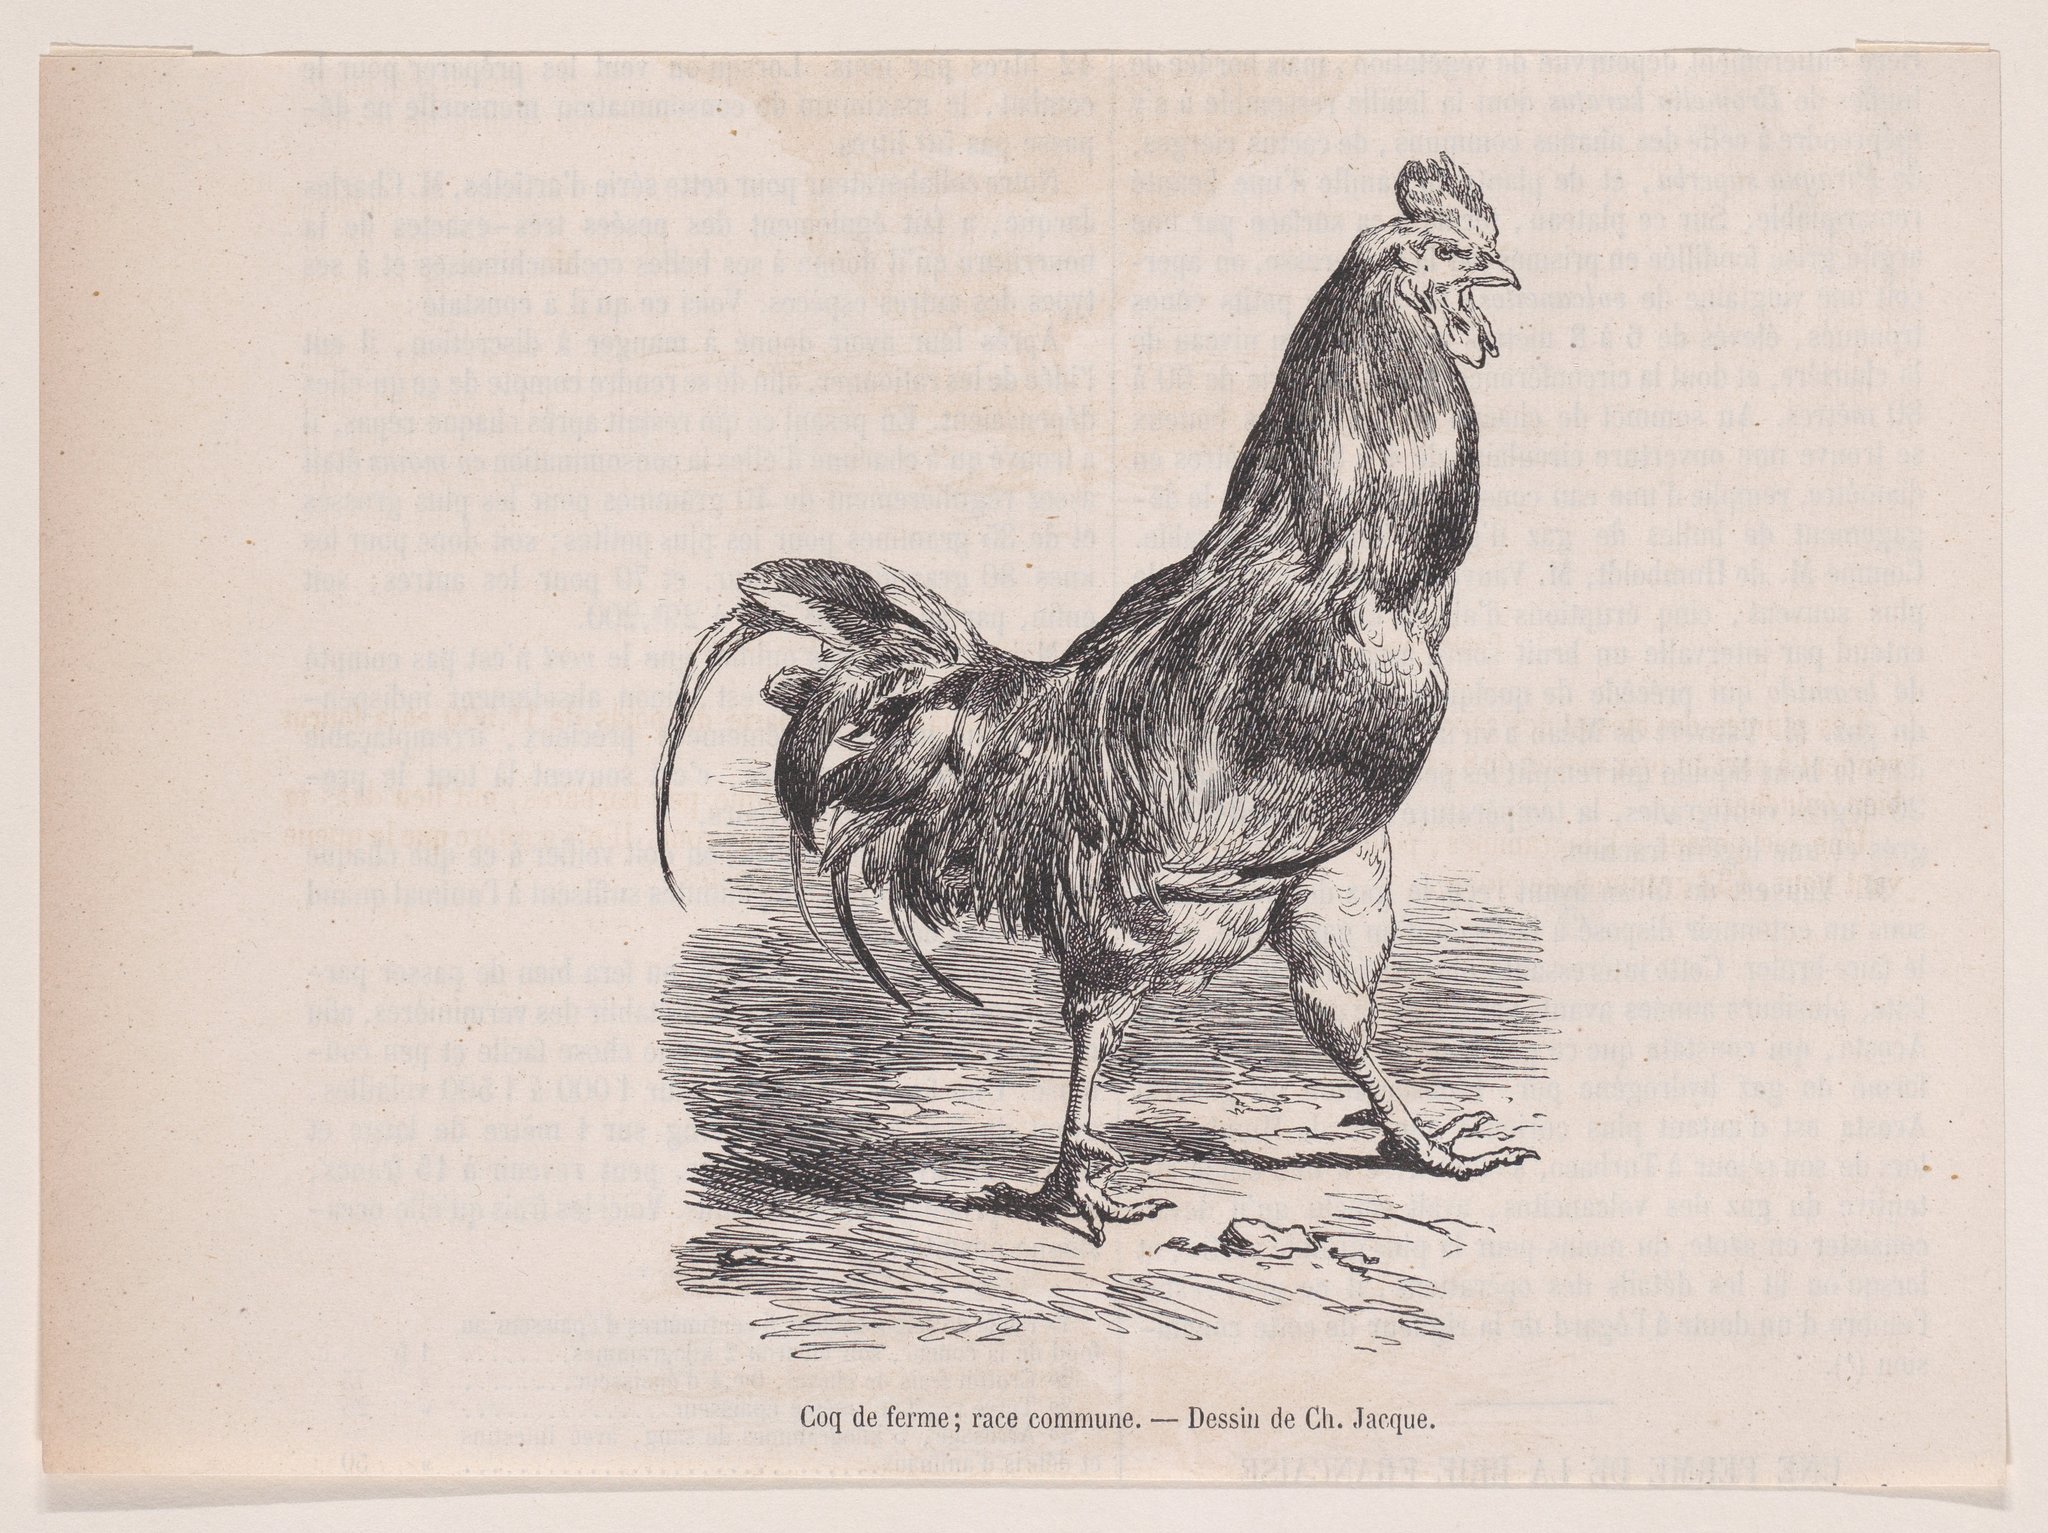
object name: print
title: Coq de ferme; race commune, from "Le Magasin Pittoresque"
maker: charles émile jacque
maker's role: artist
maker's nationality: french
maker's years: 1813-1894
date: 1852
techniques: engraving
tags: roosters